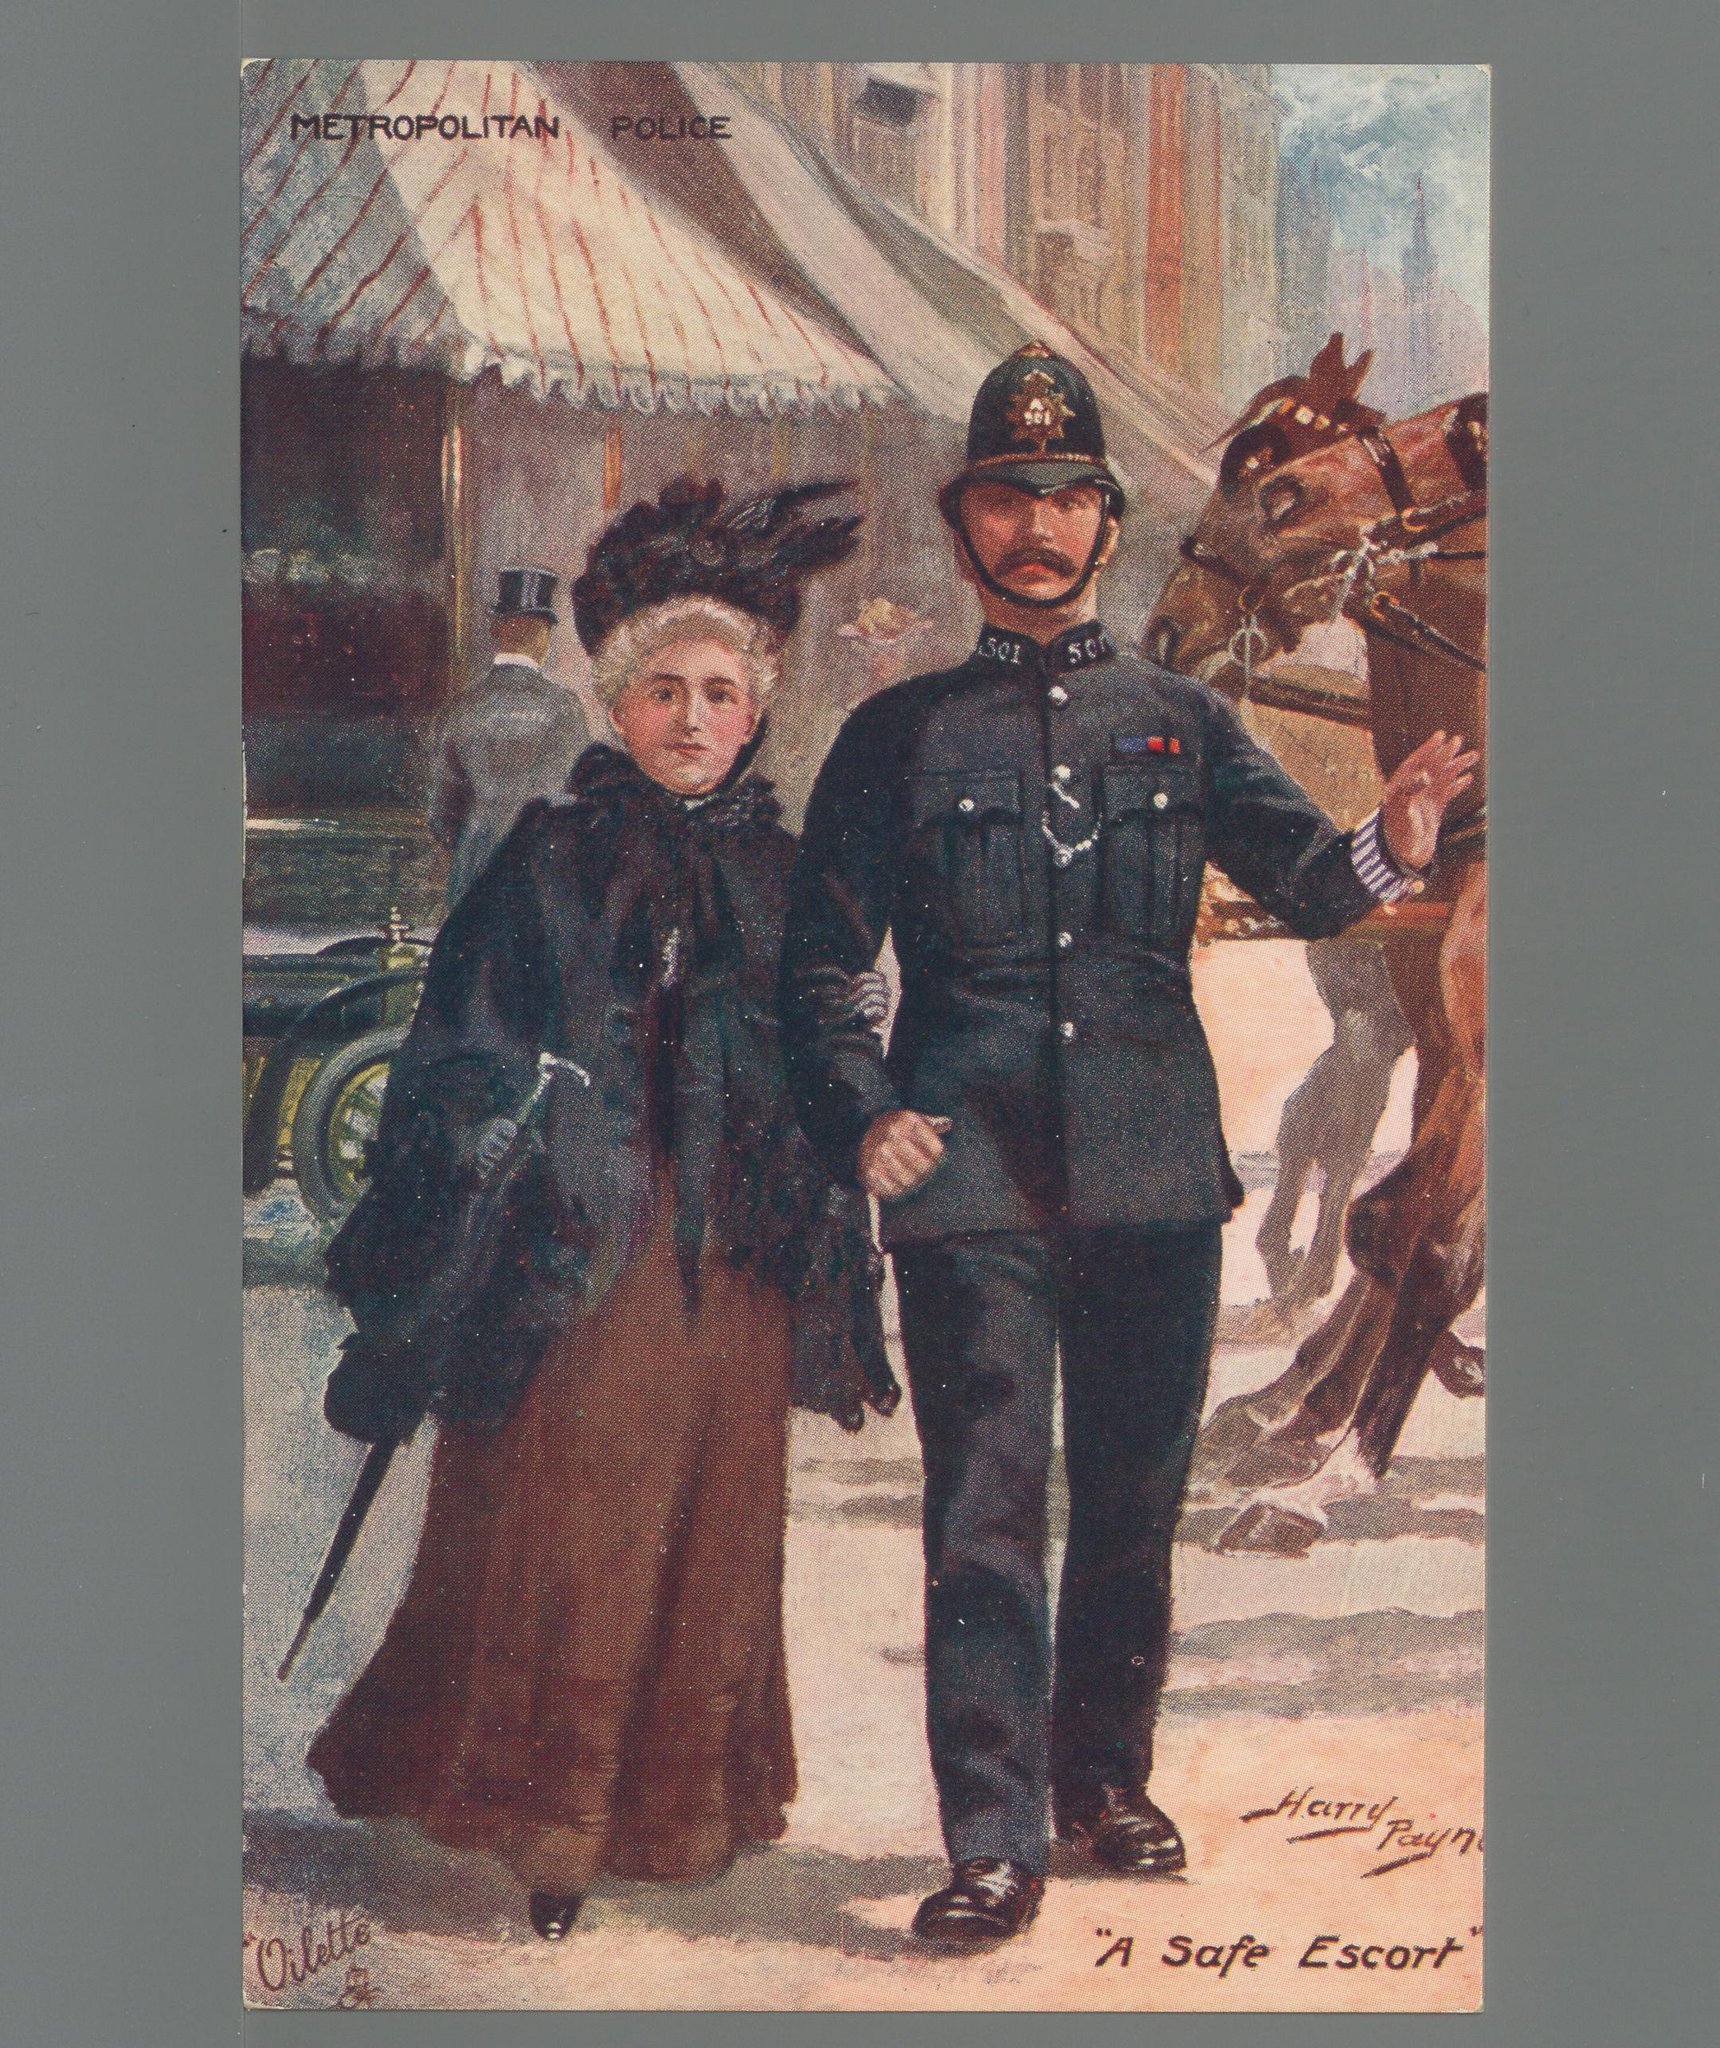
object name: reproduction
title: Metropolitan Police. "A Safe Escort"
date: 1911-1914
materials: cardboard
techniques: color autotype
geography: england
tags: policeman, constable, london